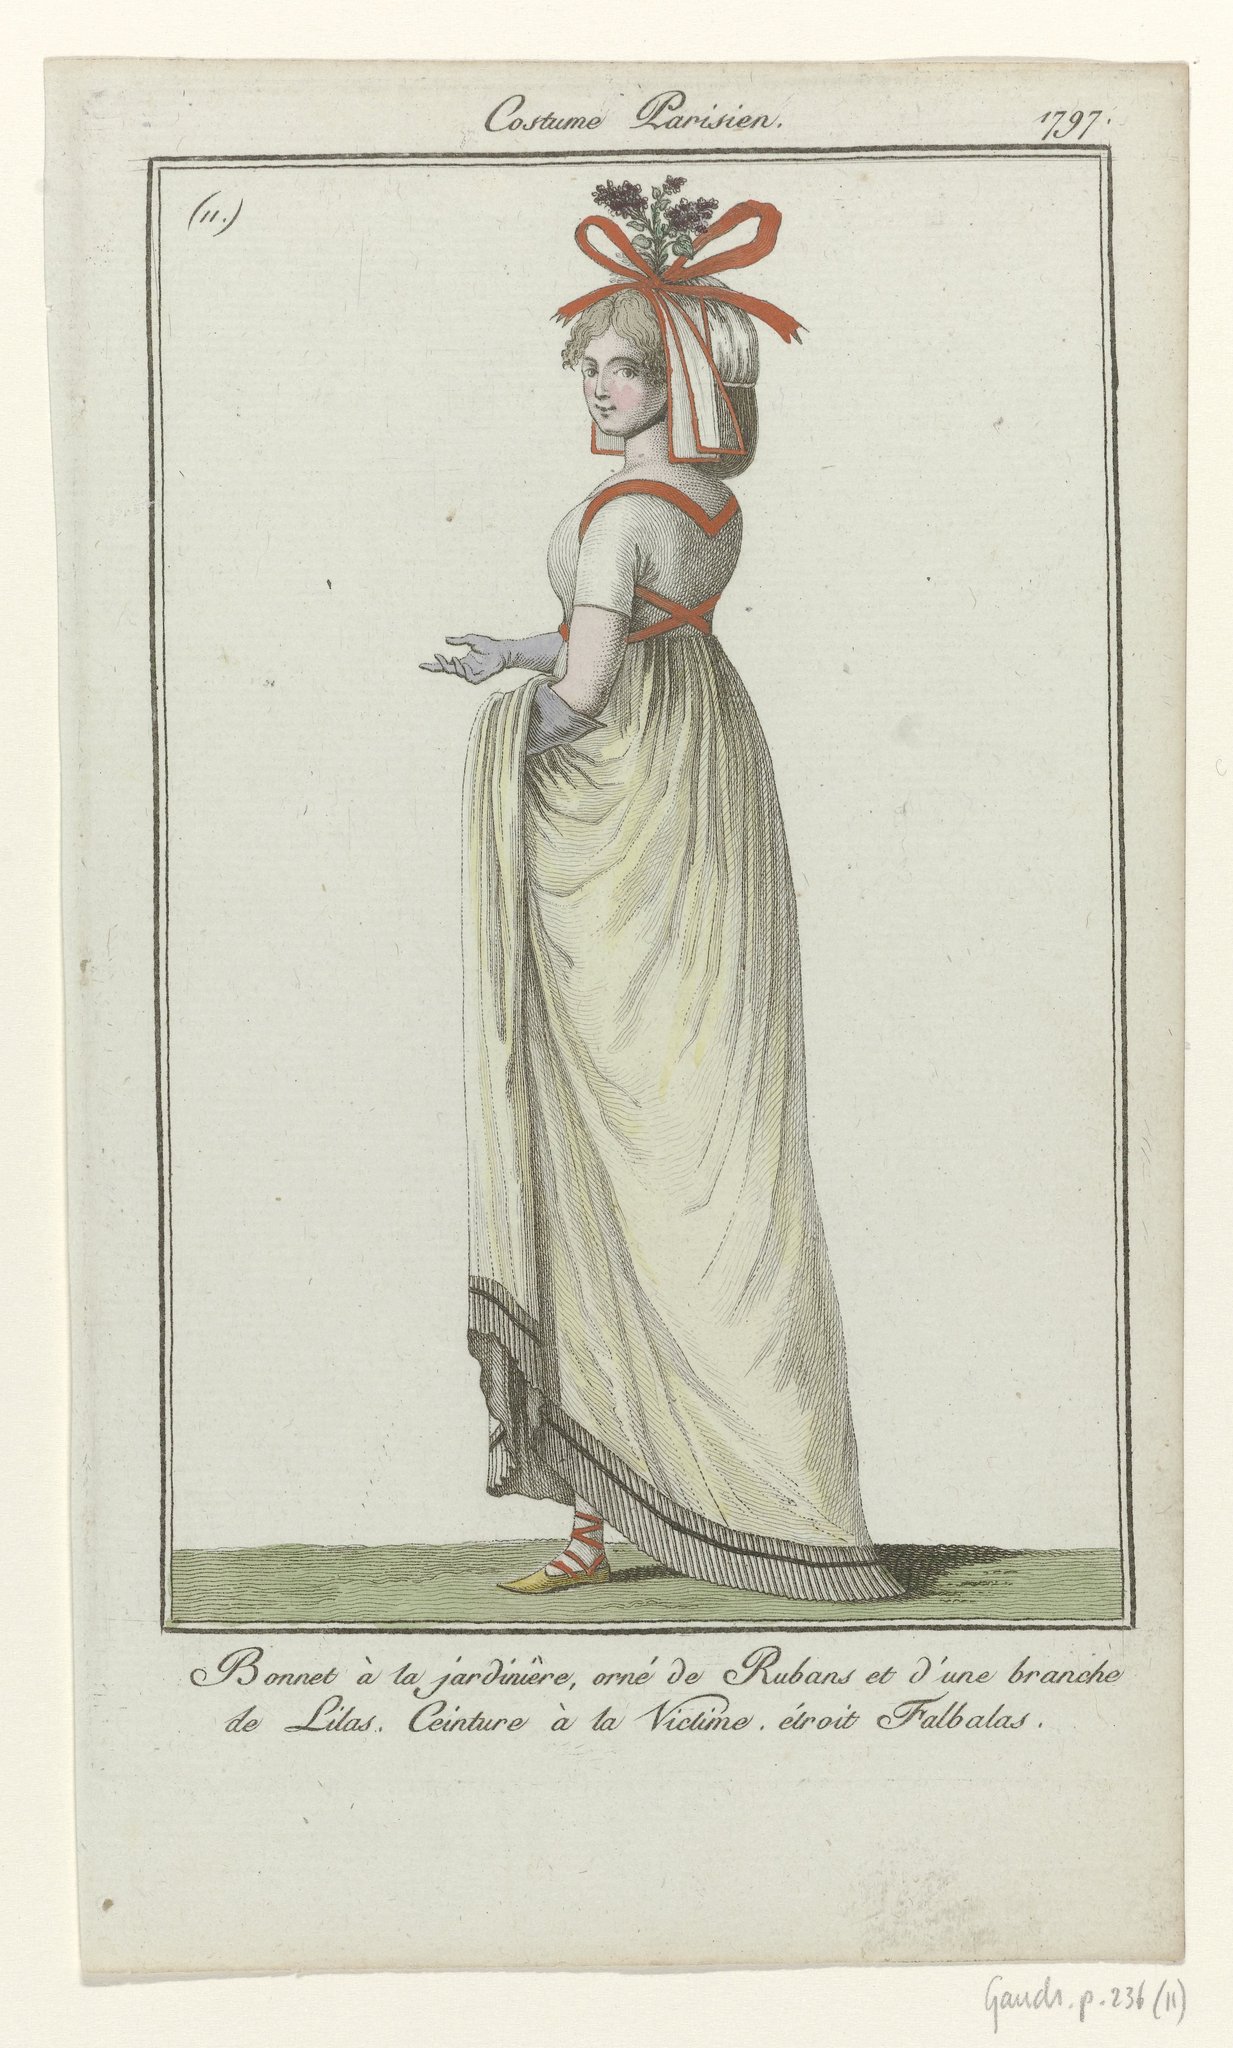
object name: fashion print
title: Journal des Dames et des Modes: Ladies’ Fashion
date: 1797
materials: paper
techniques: engraving, hand coloring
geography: paris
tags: cut flowers; nosegay, bunch of flowers, gloves, mittens (long gloves) (+ women's clothes), head-gear: cap (+ women's clothes), fashion plates, dress, gown (+ women's clothes), shoes, sandals, belt, girdle, waistband (+ women's clothes)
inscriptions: caption: ‘Bonnet à la jardinière, orné de Rubans et d'une branche de Lilas. Ceinture à la Victime, étroit Falbalas’, title: ‘Costume Parisien.’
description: After the turbulent years of the French Revolution, in 1797 a fashion magazine was finally published again: the Journal des Dames et des Modes. Under the direction of Pierre de La Mésangère, it developed a cosmopolitan flair. The very best draughtsmen were recruited to produce the fashion illustrations, called Costumes Parisiens. They visited spots all over Paris to ensure they saw the latest styles. These included high-waisted gowns with low necklines, ‘Greek’ slippers with cross-laces 1, genuine Kashmiri shawls 2, reticules 3 (small stylish handbags), poke bonnets 4 and full-length English coats knowns as redingotes 5.